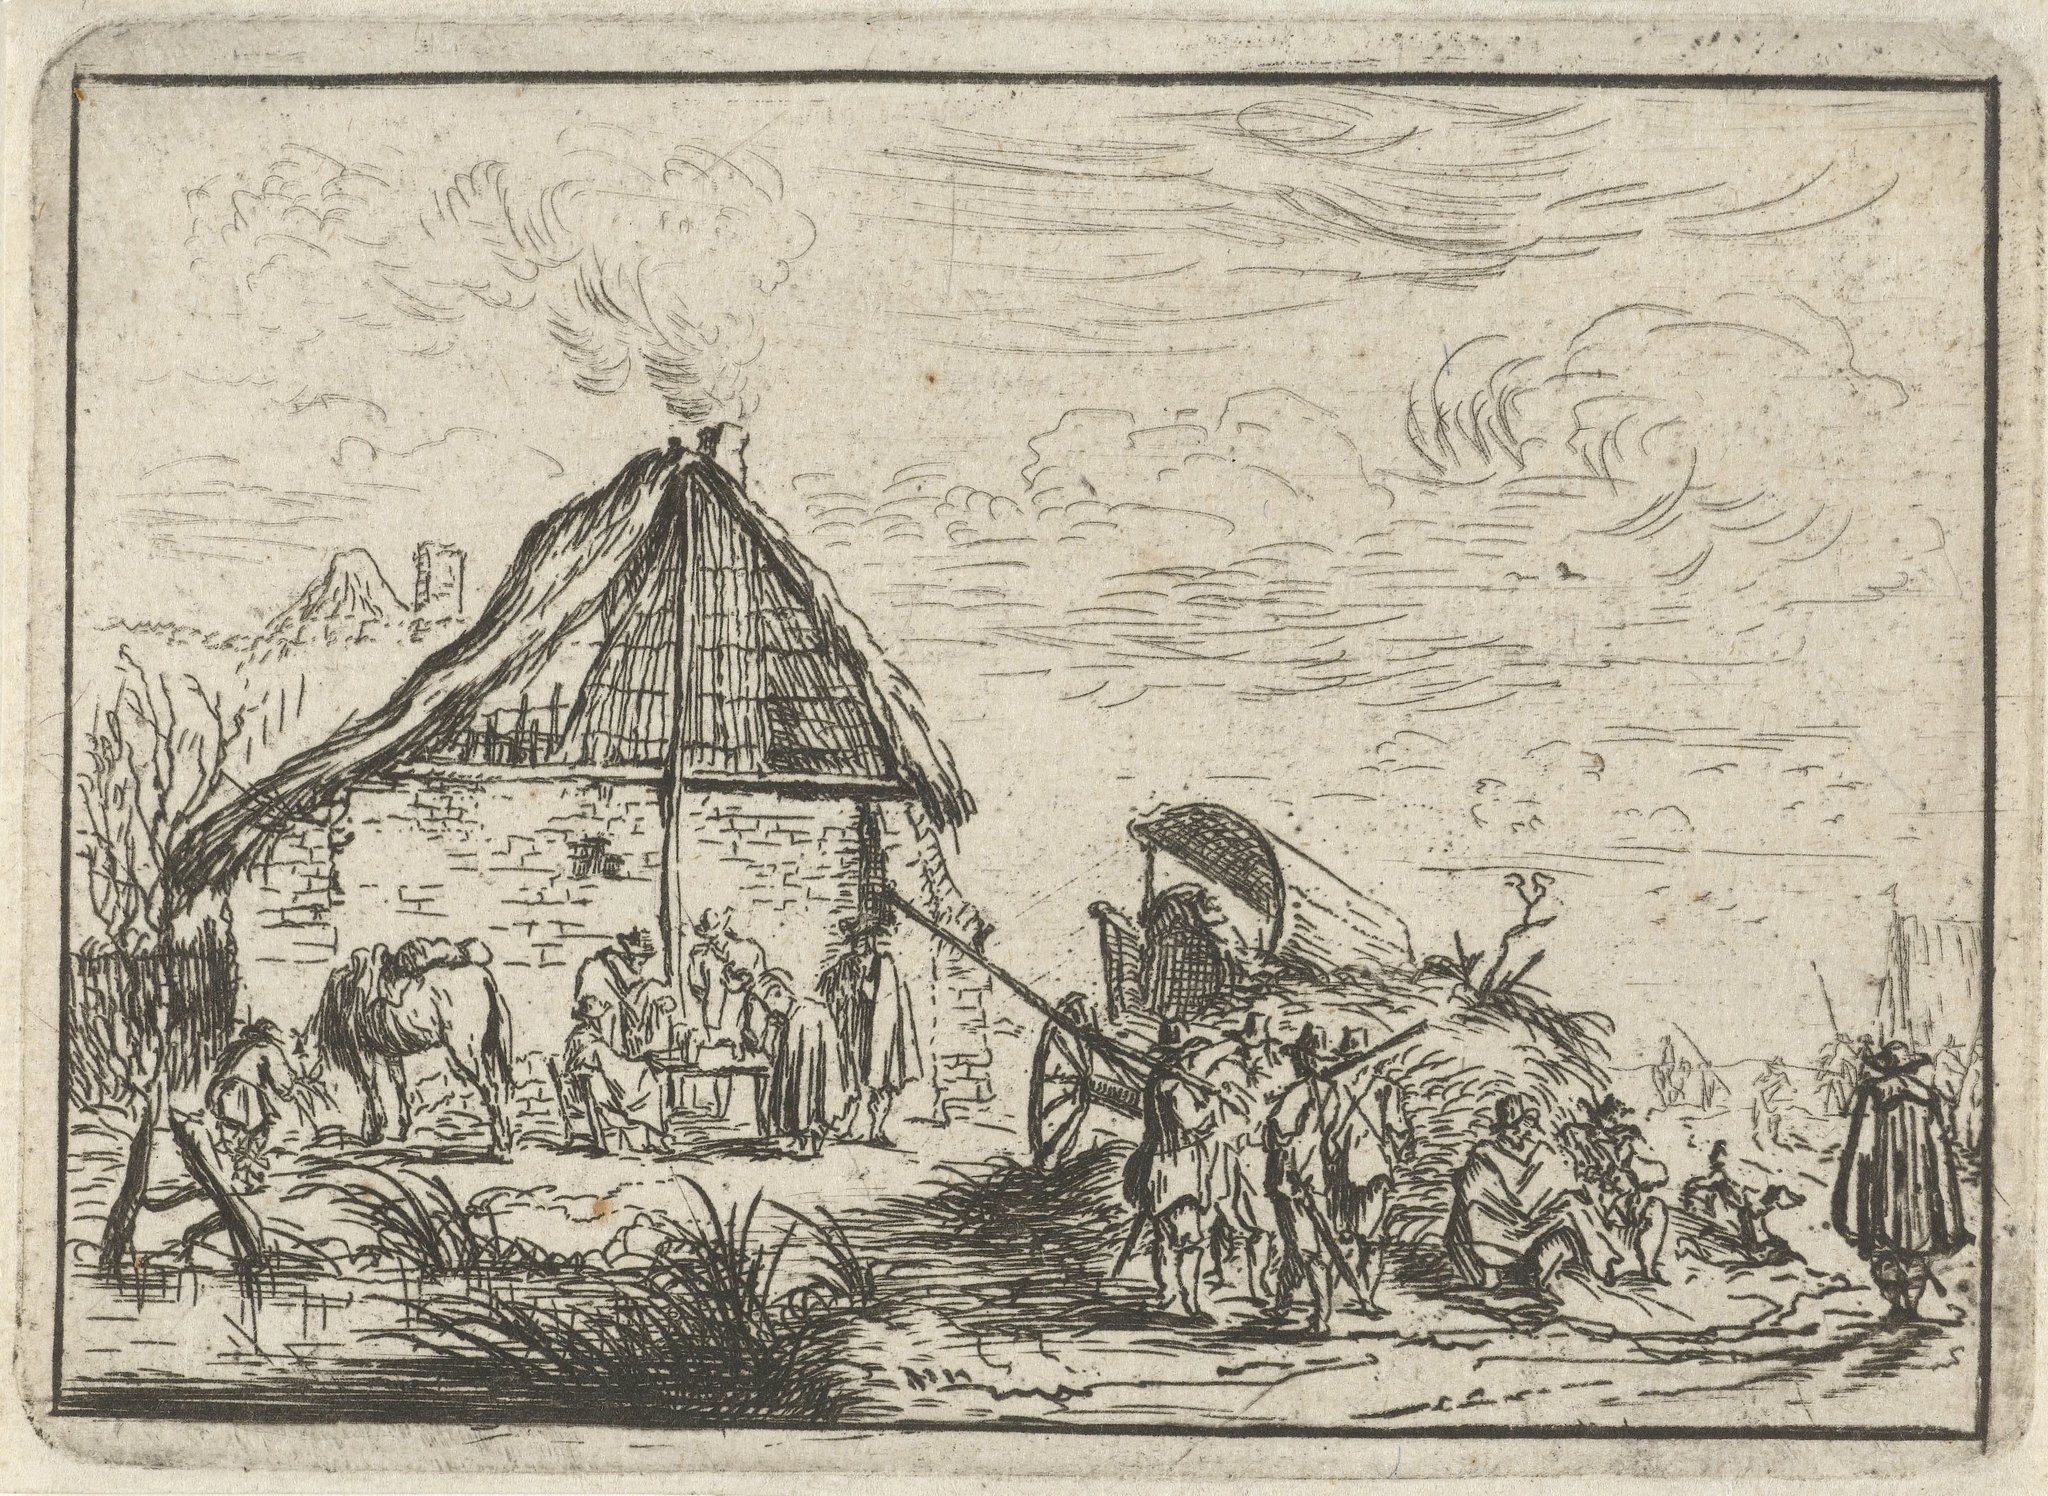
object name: print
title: Landschappen met kampementen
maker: robert van den hoecke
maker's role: draughtsman, painter, print maker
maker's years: 1622-1668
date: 1632-1668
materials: paper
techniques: etching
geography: southern netherlands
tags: riding a horse, ass, or mule; rider, horseman, hay-stack, the soldier off duty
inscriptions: collector's mark: Lugt 240